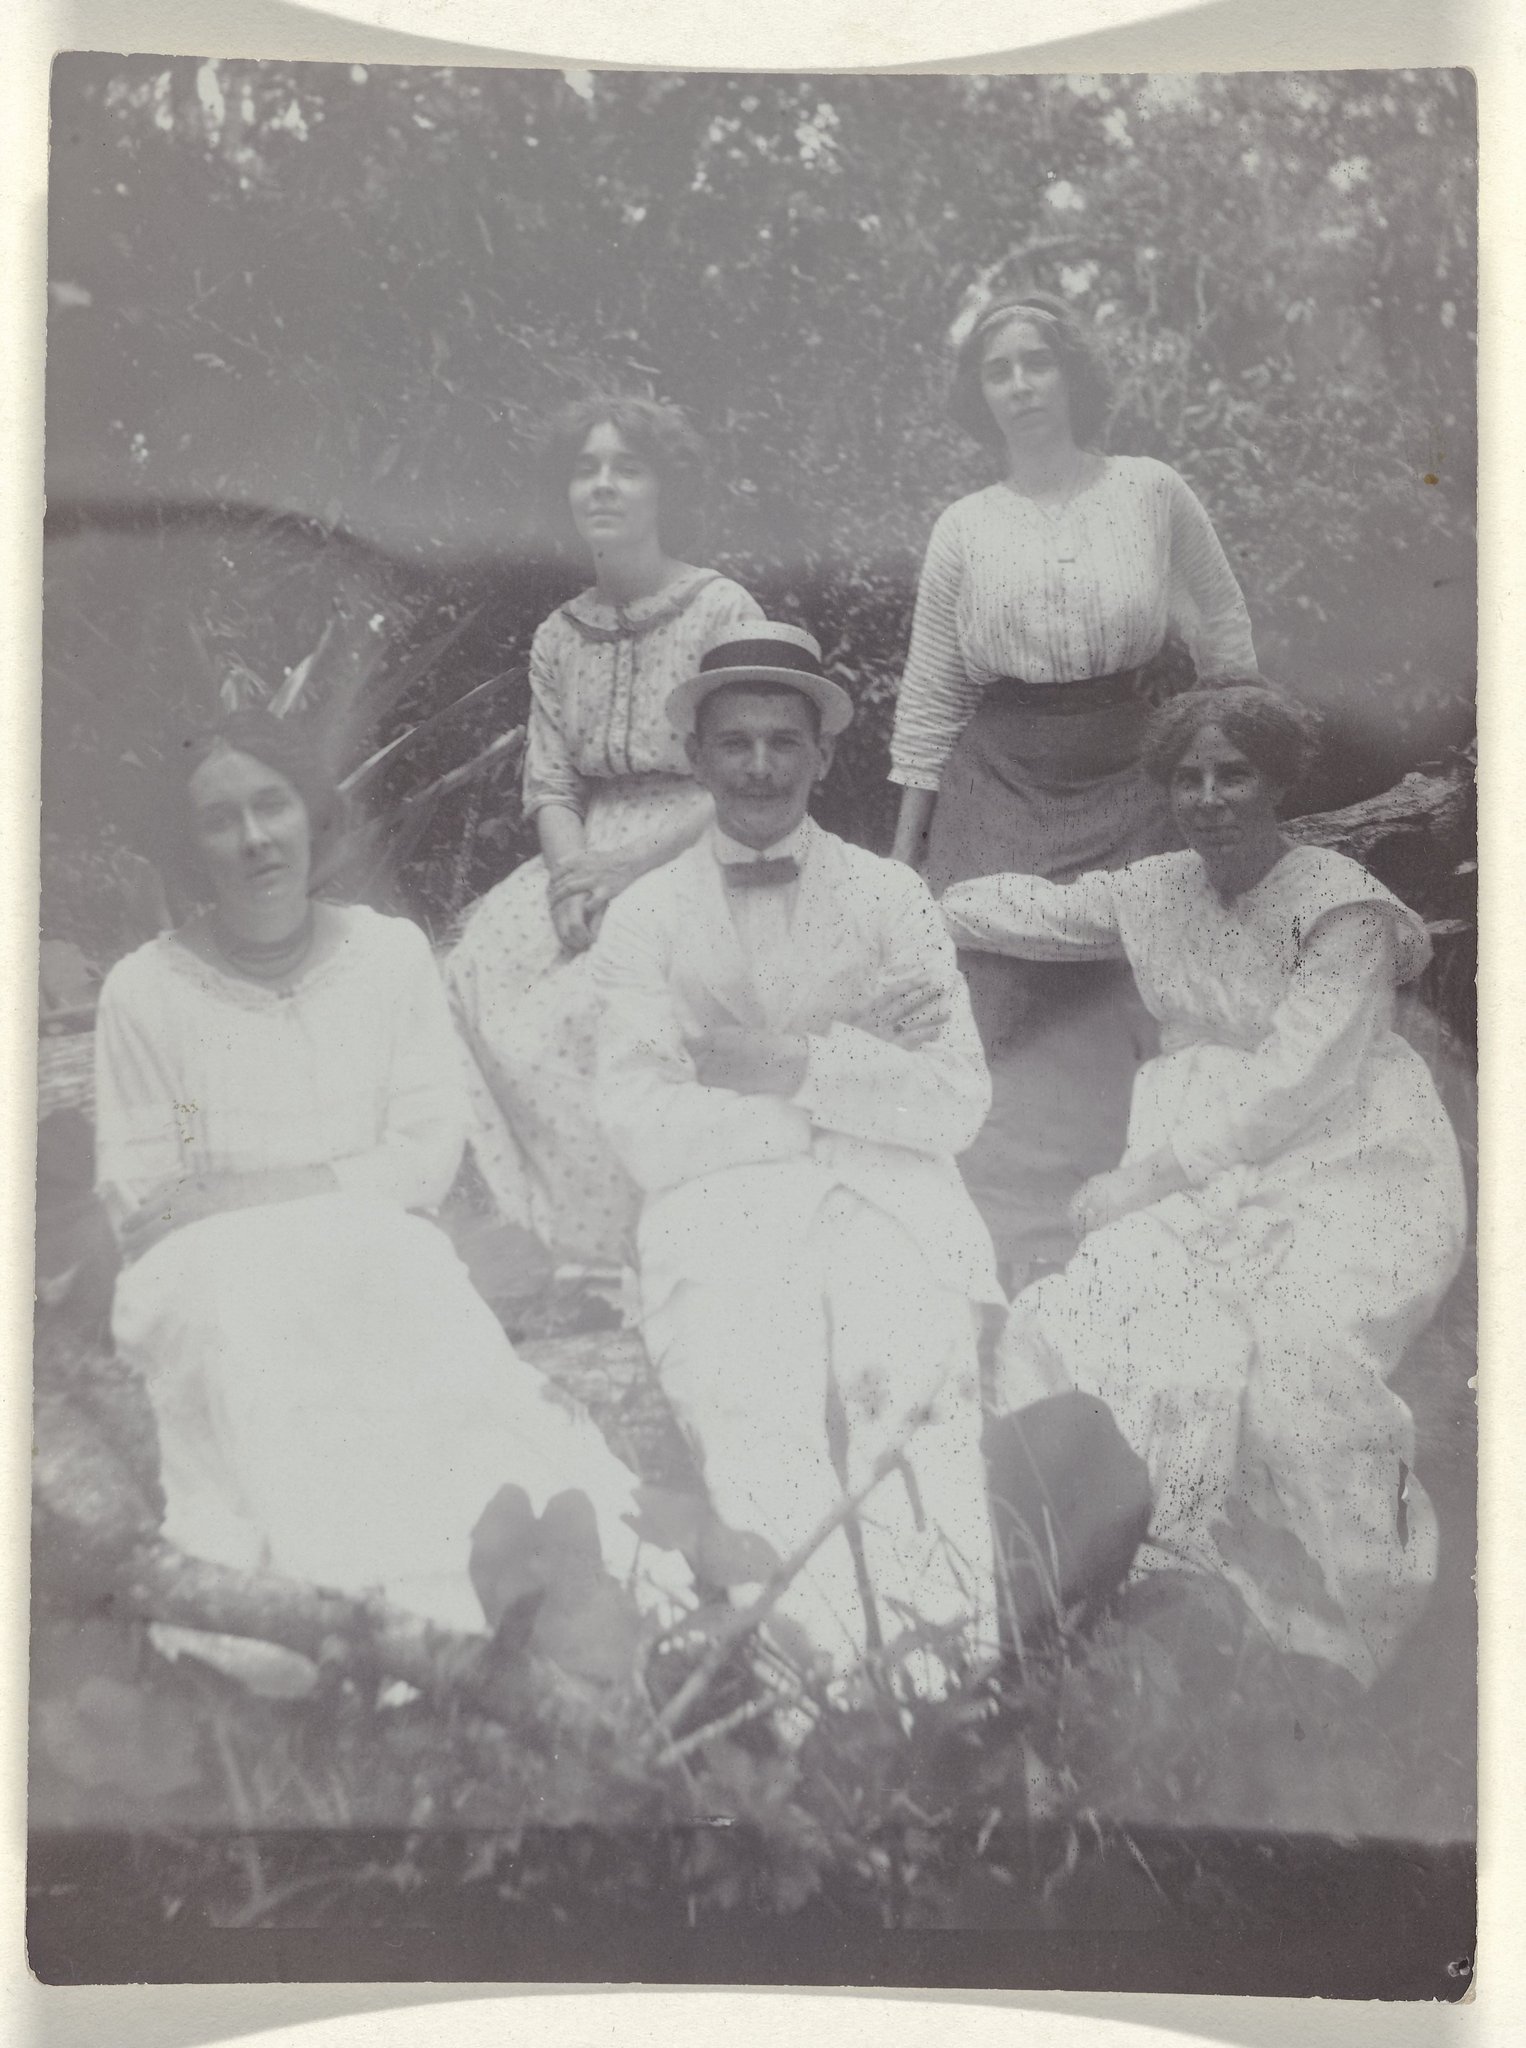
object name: photograph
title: Gezelschap op een plantage, met links Maria Gonggrijp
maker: andries augustus boom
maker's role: amateurfotograaf, handelaar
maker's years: 1878-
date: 1911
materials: photographic support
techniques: photography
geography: suriname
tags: plantation, suriname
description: Gezelschap van vijf personen op een plantage. Linksvoor Maria Gonggrijp. Rechtsvoor Louise Catharina Spiering van plantage Morgenstond met haar dochters linksachter Stephanie (Nita) Gonggrijp en rechtsachter Anna Barbara (Annie). Onderdeel van een groep foto's van de familie Boom-Gonggrijp in Suriname.